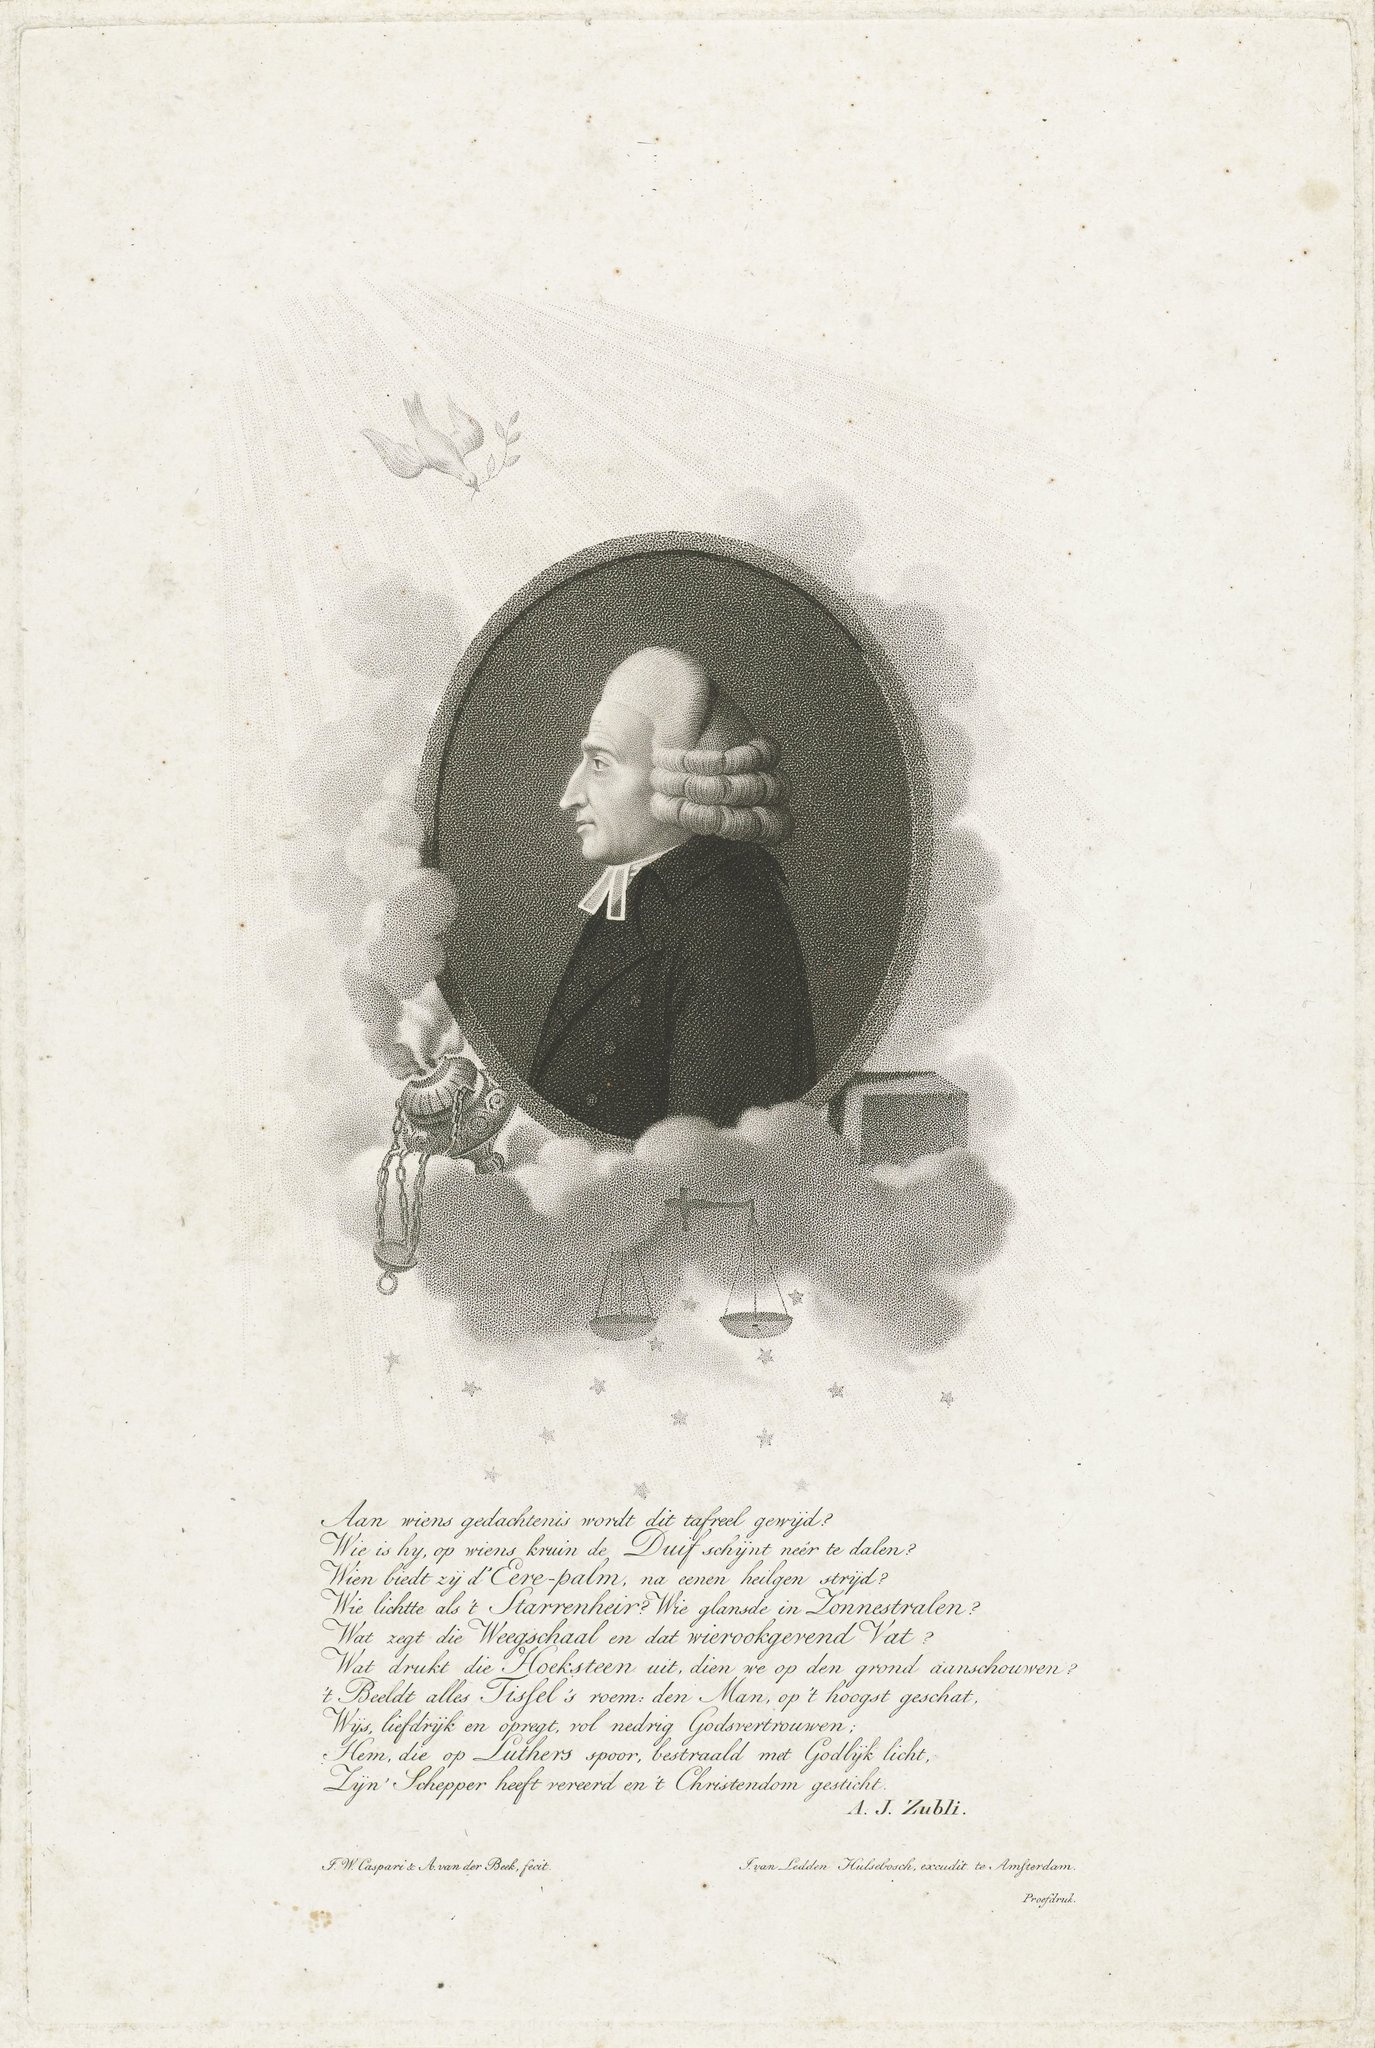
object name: print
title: Portret van Johannes Tissel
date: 1793-1822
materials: paper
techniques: etching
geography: amsterdam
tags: predikant, johannes tissel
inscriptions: collector's mark: Lugt 2166, inscription: ‘proefdruk’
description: Portret in ovale lijst van Johannes Tissel, Luthers predikant van Amsterdam. Buste naar links. Pauw heeft een zwarte jas aan met een witte bef. De prent heeft een Nederlands gedicht als onderschrift